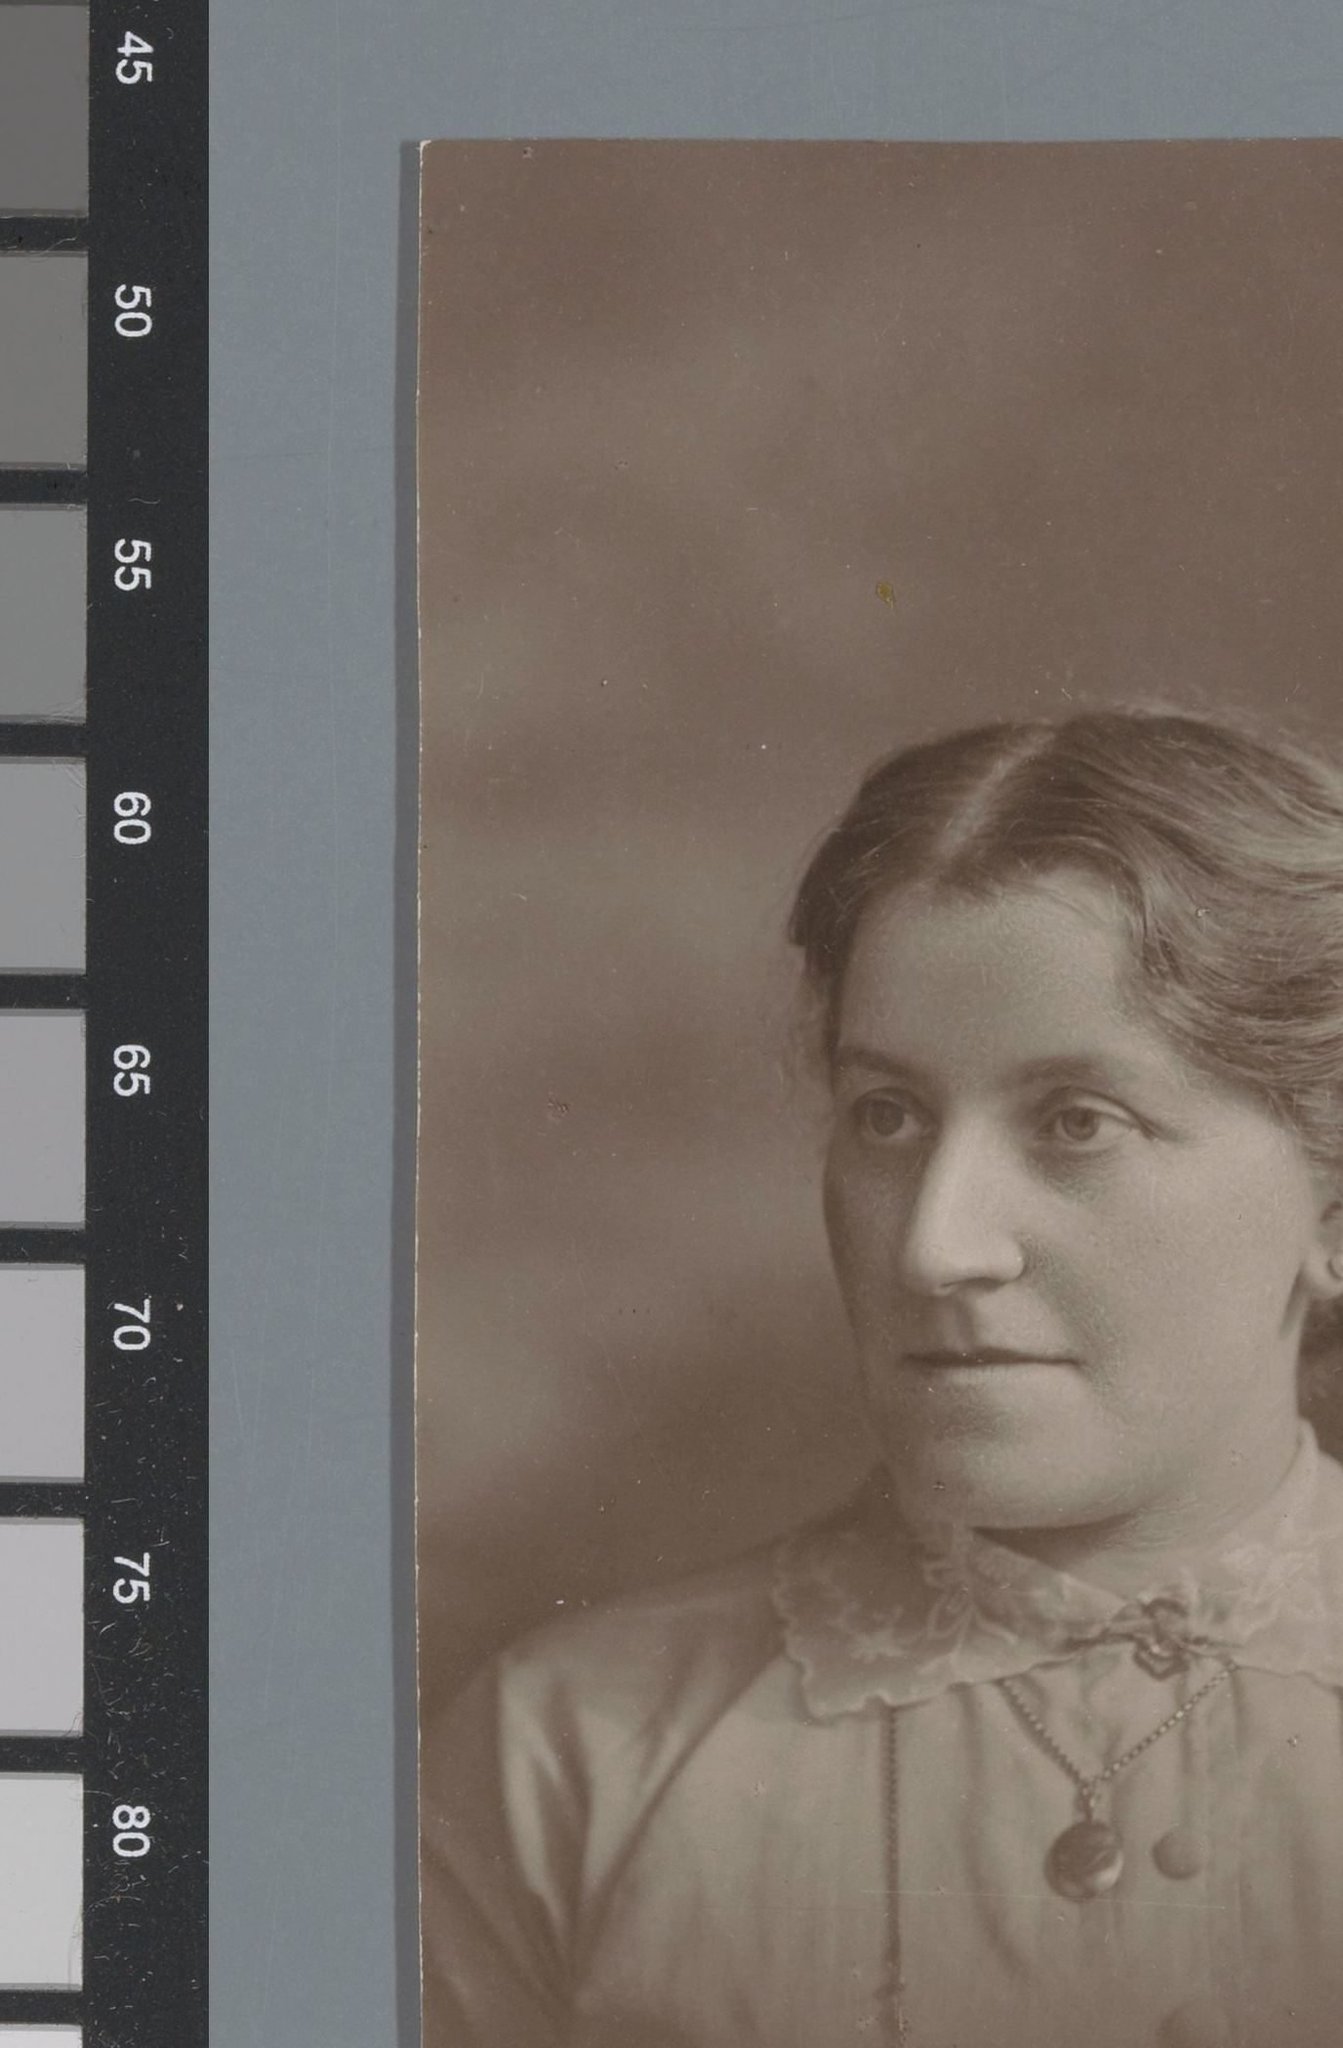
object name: ansichtkaart, prentbriefkaart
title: Portret van een onbekende vrouw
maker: Anonymous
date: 1915-1930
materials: photographic support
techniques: gelatin silver print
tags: adult woman